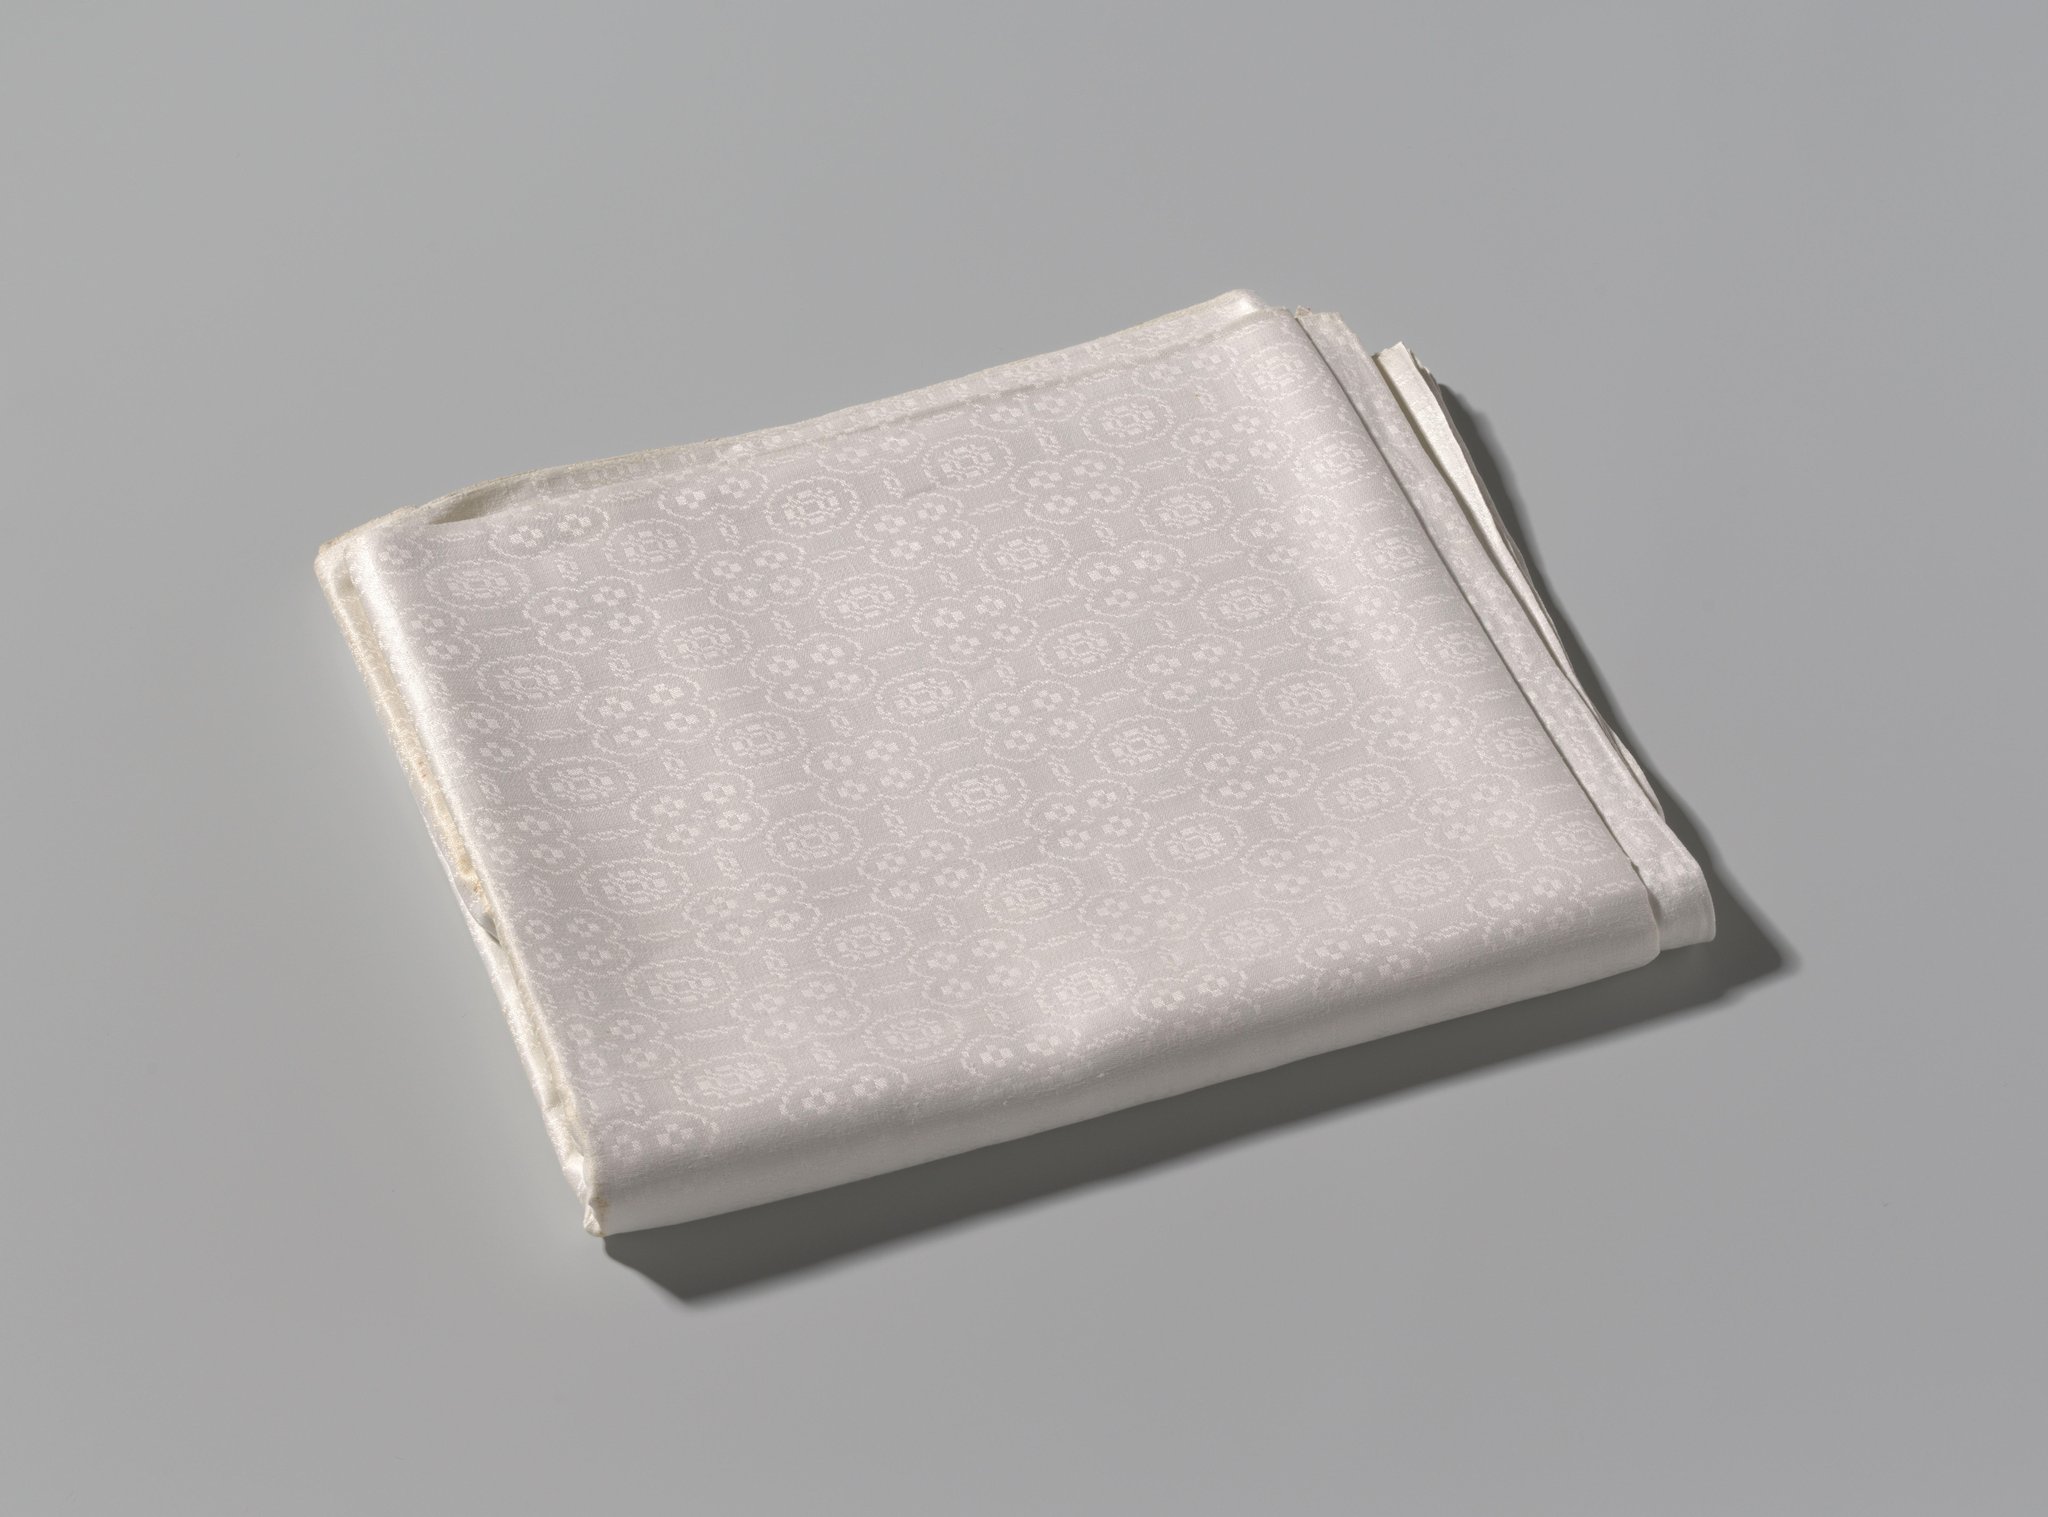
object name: tablecloth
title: Tafellaken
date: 1400-1950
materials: linen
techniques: peeled fabric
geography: northern netherlands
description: Wit linnen tafellaken met een pellen patroon, merk (?)(?)R 4.